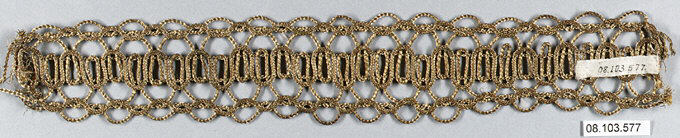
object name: galloon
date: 1701-1800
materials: metal thread